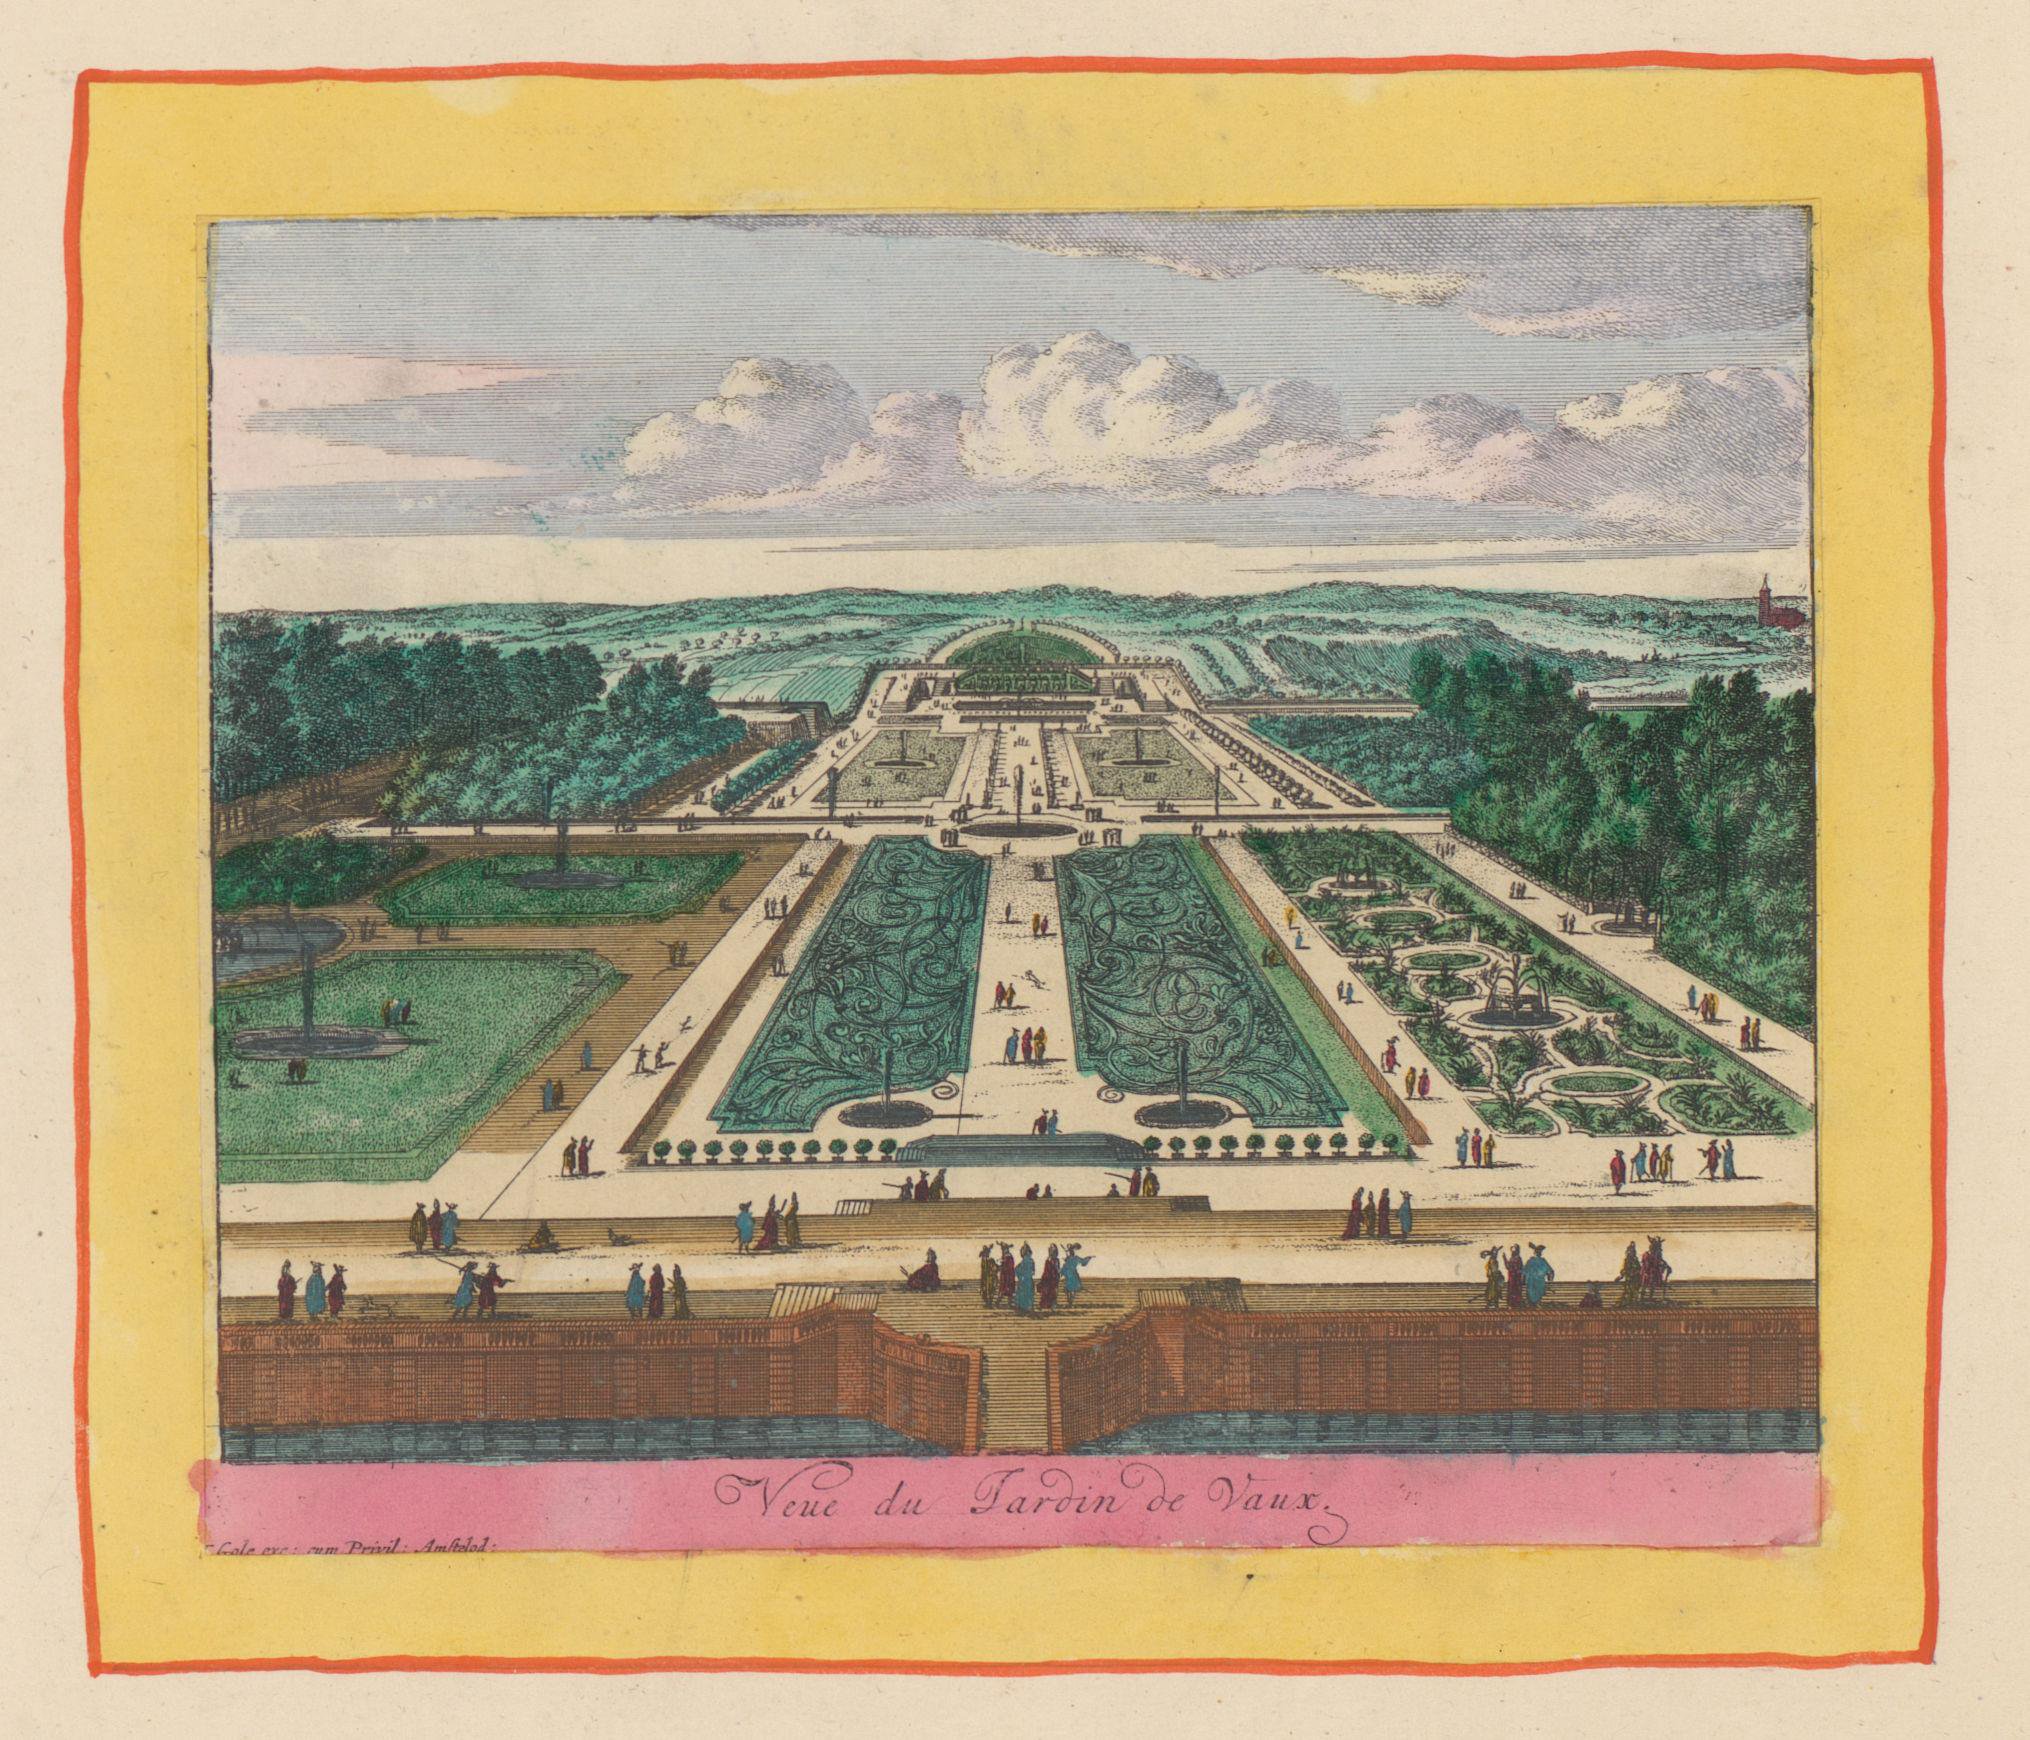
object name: print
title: Gezichten op Château de Vaux-le-Vicomte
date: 1681-1724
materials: paper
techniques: etching, hand coloring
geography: the hague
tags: french or architectonic garden; formal garden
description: Gezicht op de tuinen van Château de Vaux-le-Vicomte vanaf het kasteel. Prent maakt deel uit van een album.